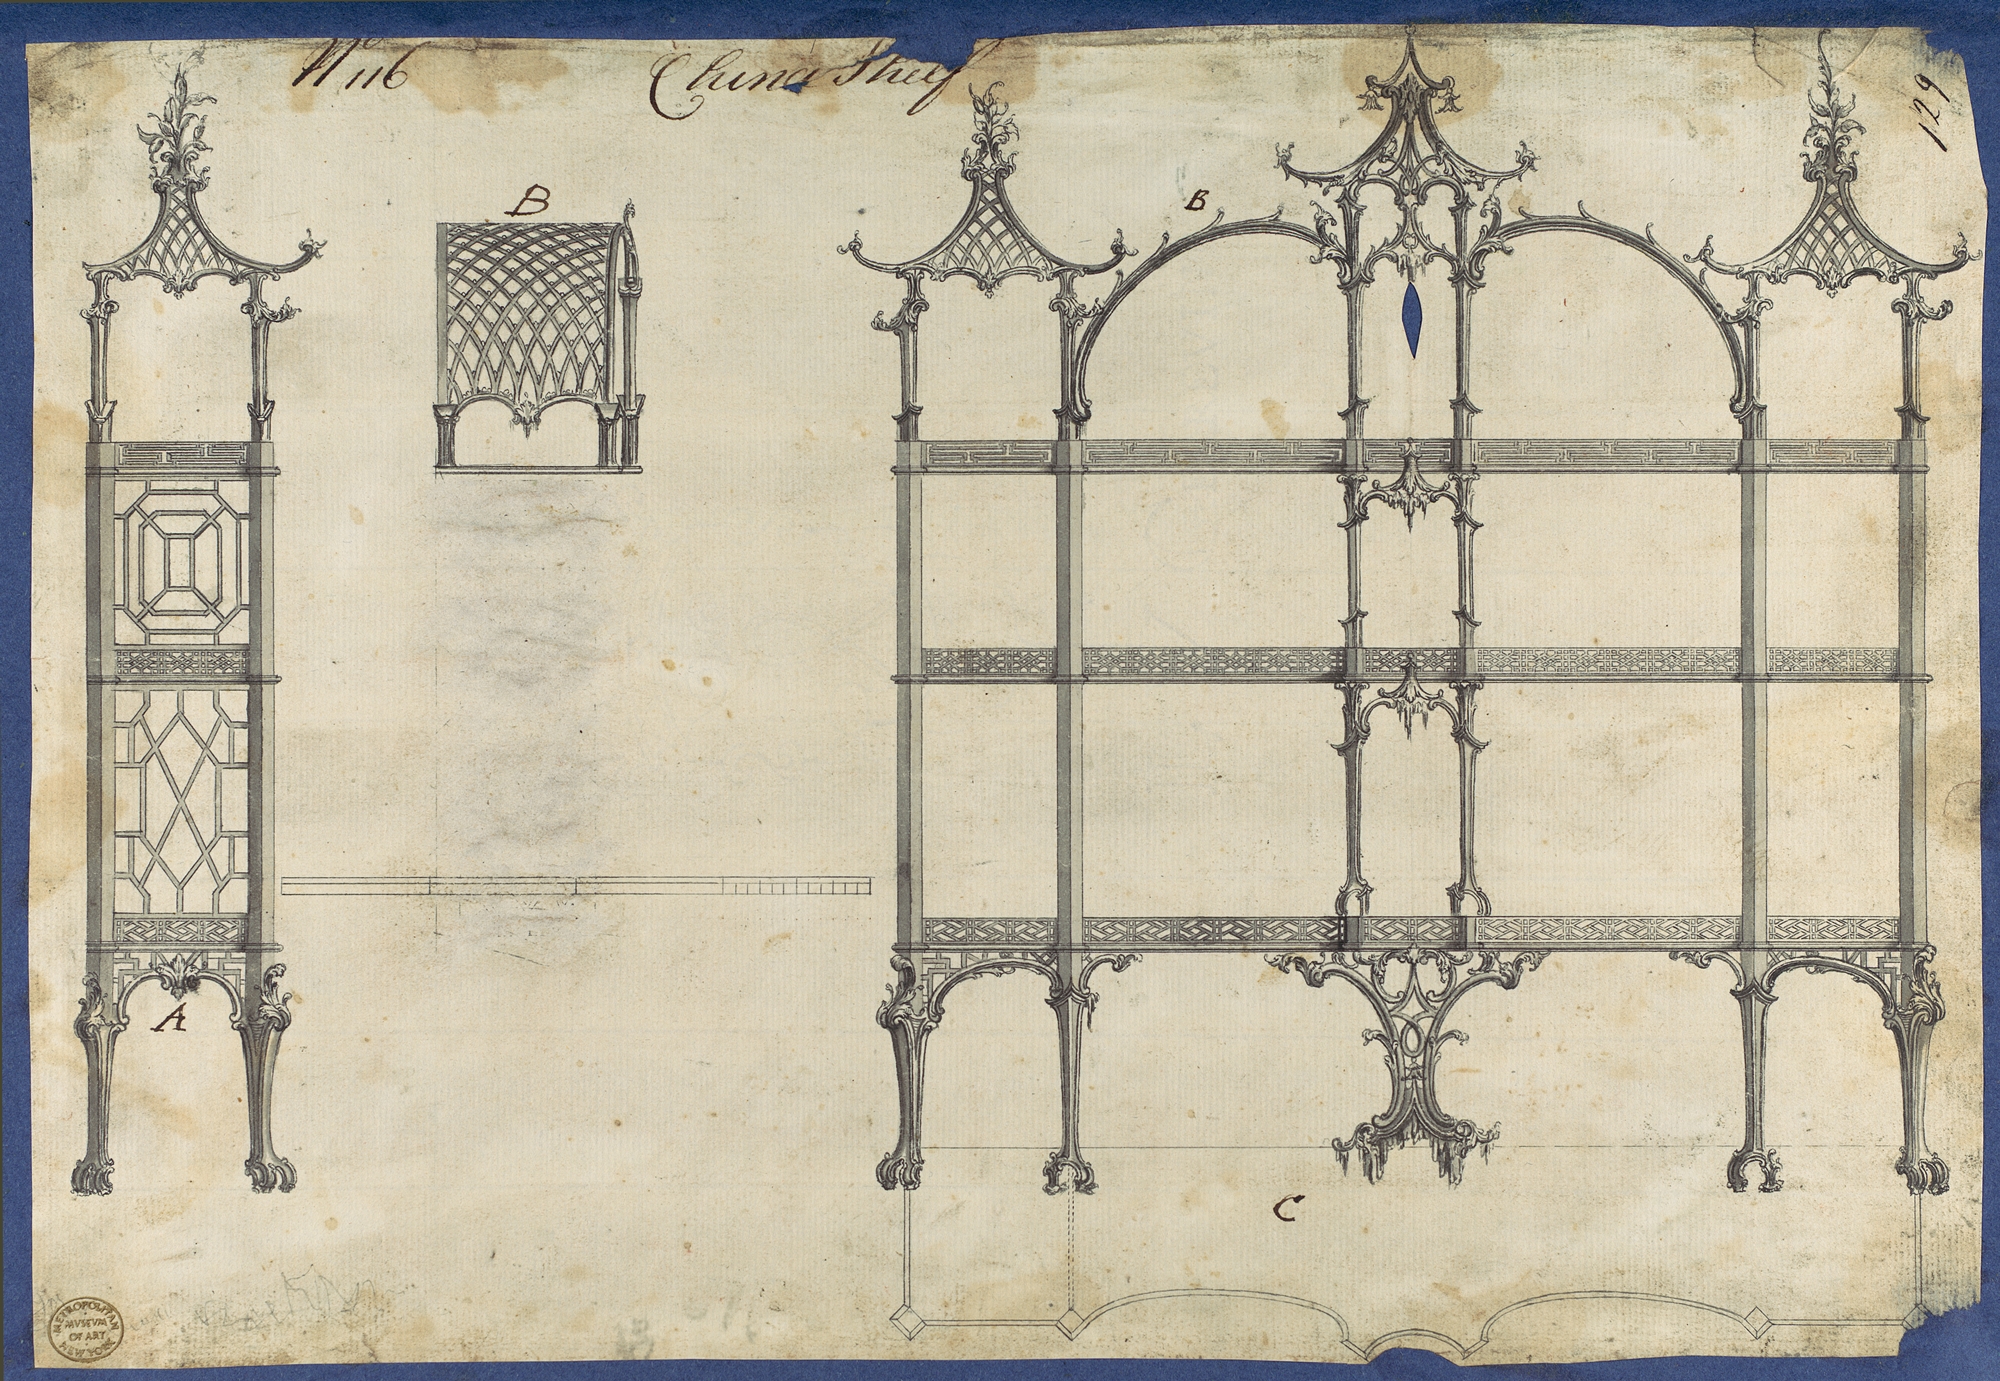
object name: drawing ornament architecture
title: China Shelf, from Chippendale Drawings, Vol. II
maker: thomas chippendale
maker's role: artist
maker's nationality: british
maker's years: 1718-1779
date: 1753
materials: ink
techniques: wash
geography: london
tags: furniture